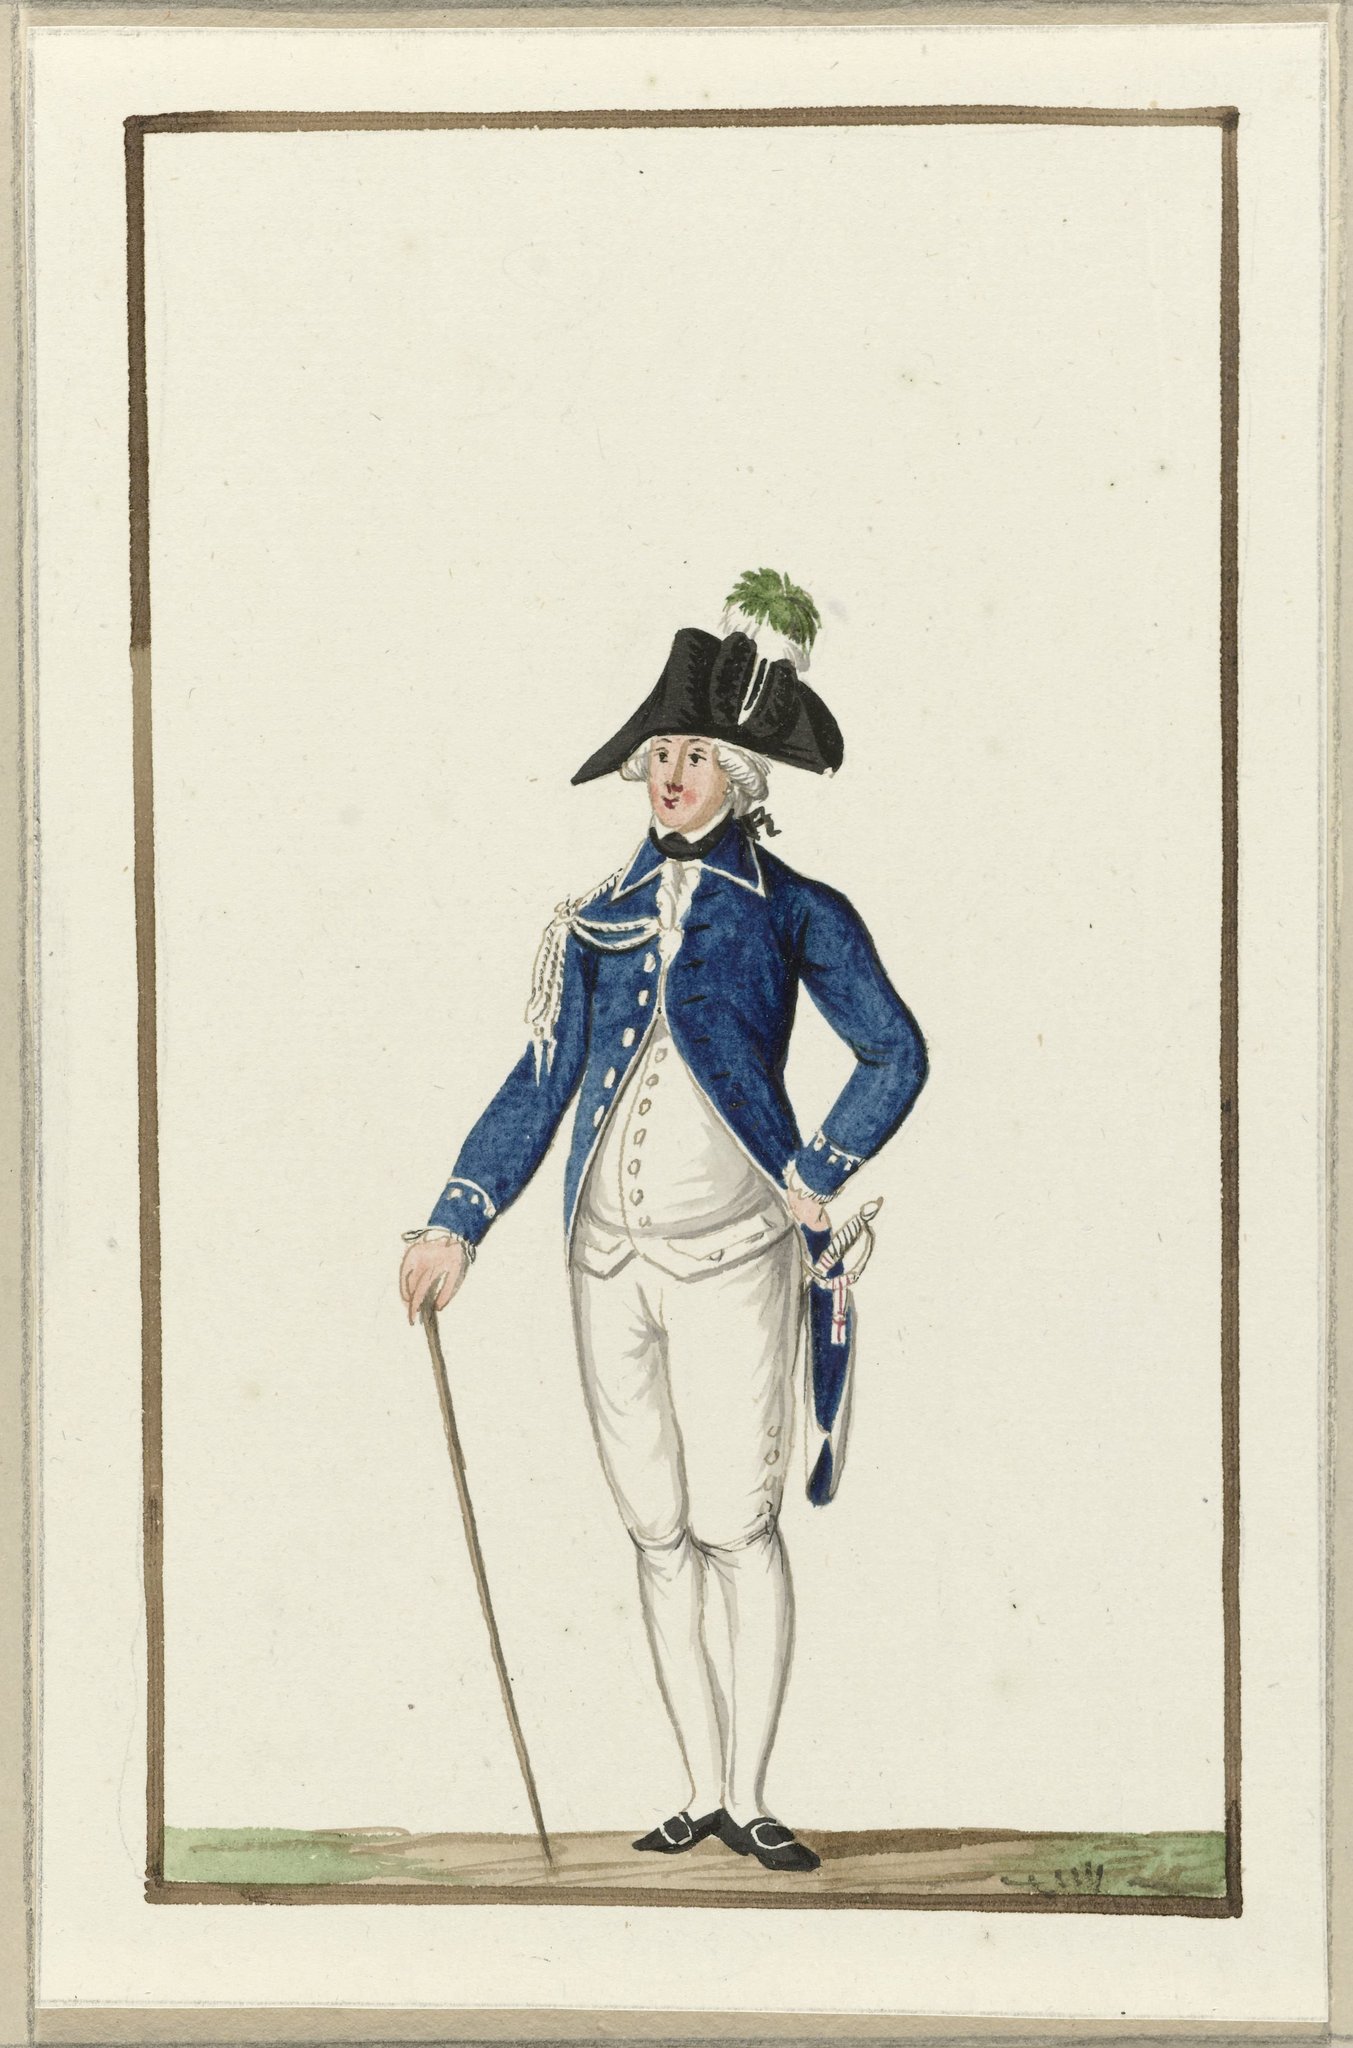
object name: drawing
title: Schuttereyen / Rotterdam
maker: Anonymous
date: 1787-1790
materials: paper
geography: northern netherlands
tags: (military) uniforms (+ citizen soldiery, civil guard, citizen militia), rotterdam, patriots (1780-1795)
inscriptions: collector's mark: Lugt 2228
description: Uniform van de schutterij van Rotterdam. Onderdeel van een serie van 32 tekeningen van de verschillende monteringen (uniformen) van patriotse schutterijen en burgerkorpsen in Nederland in 1787.